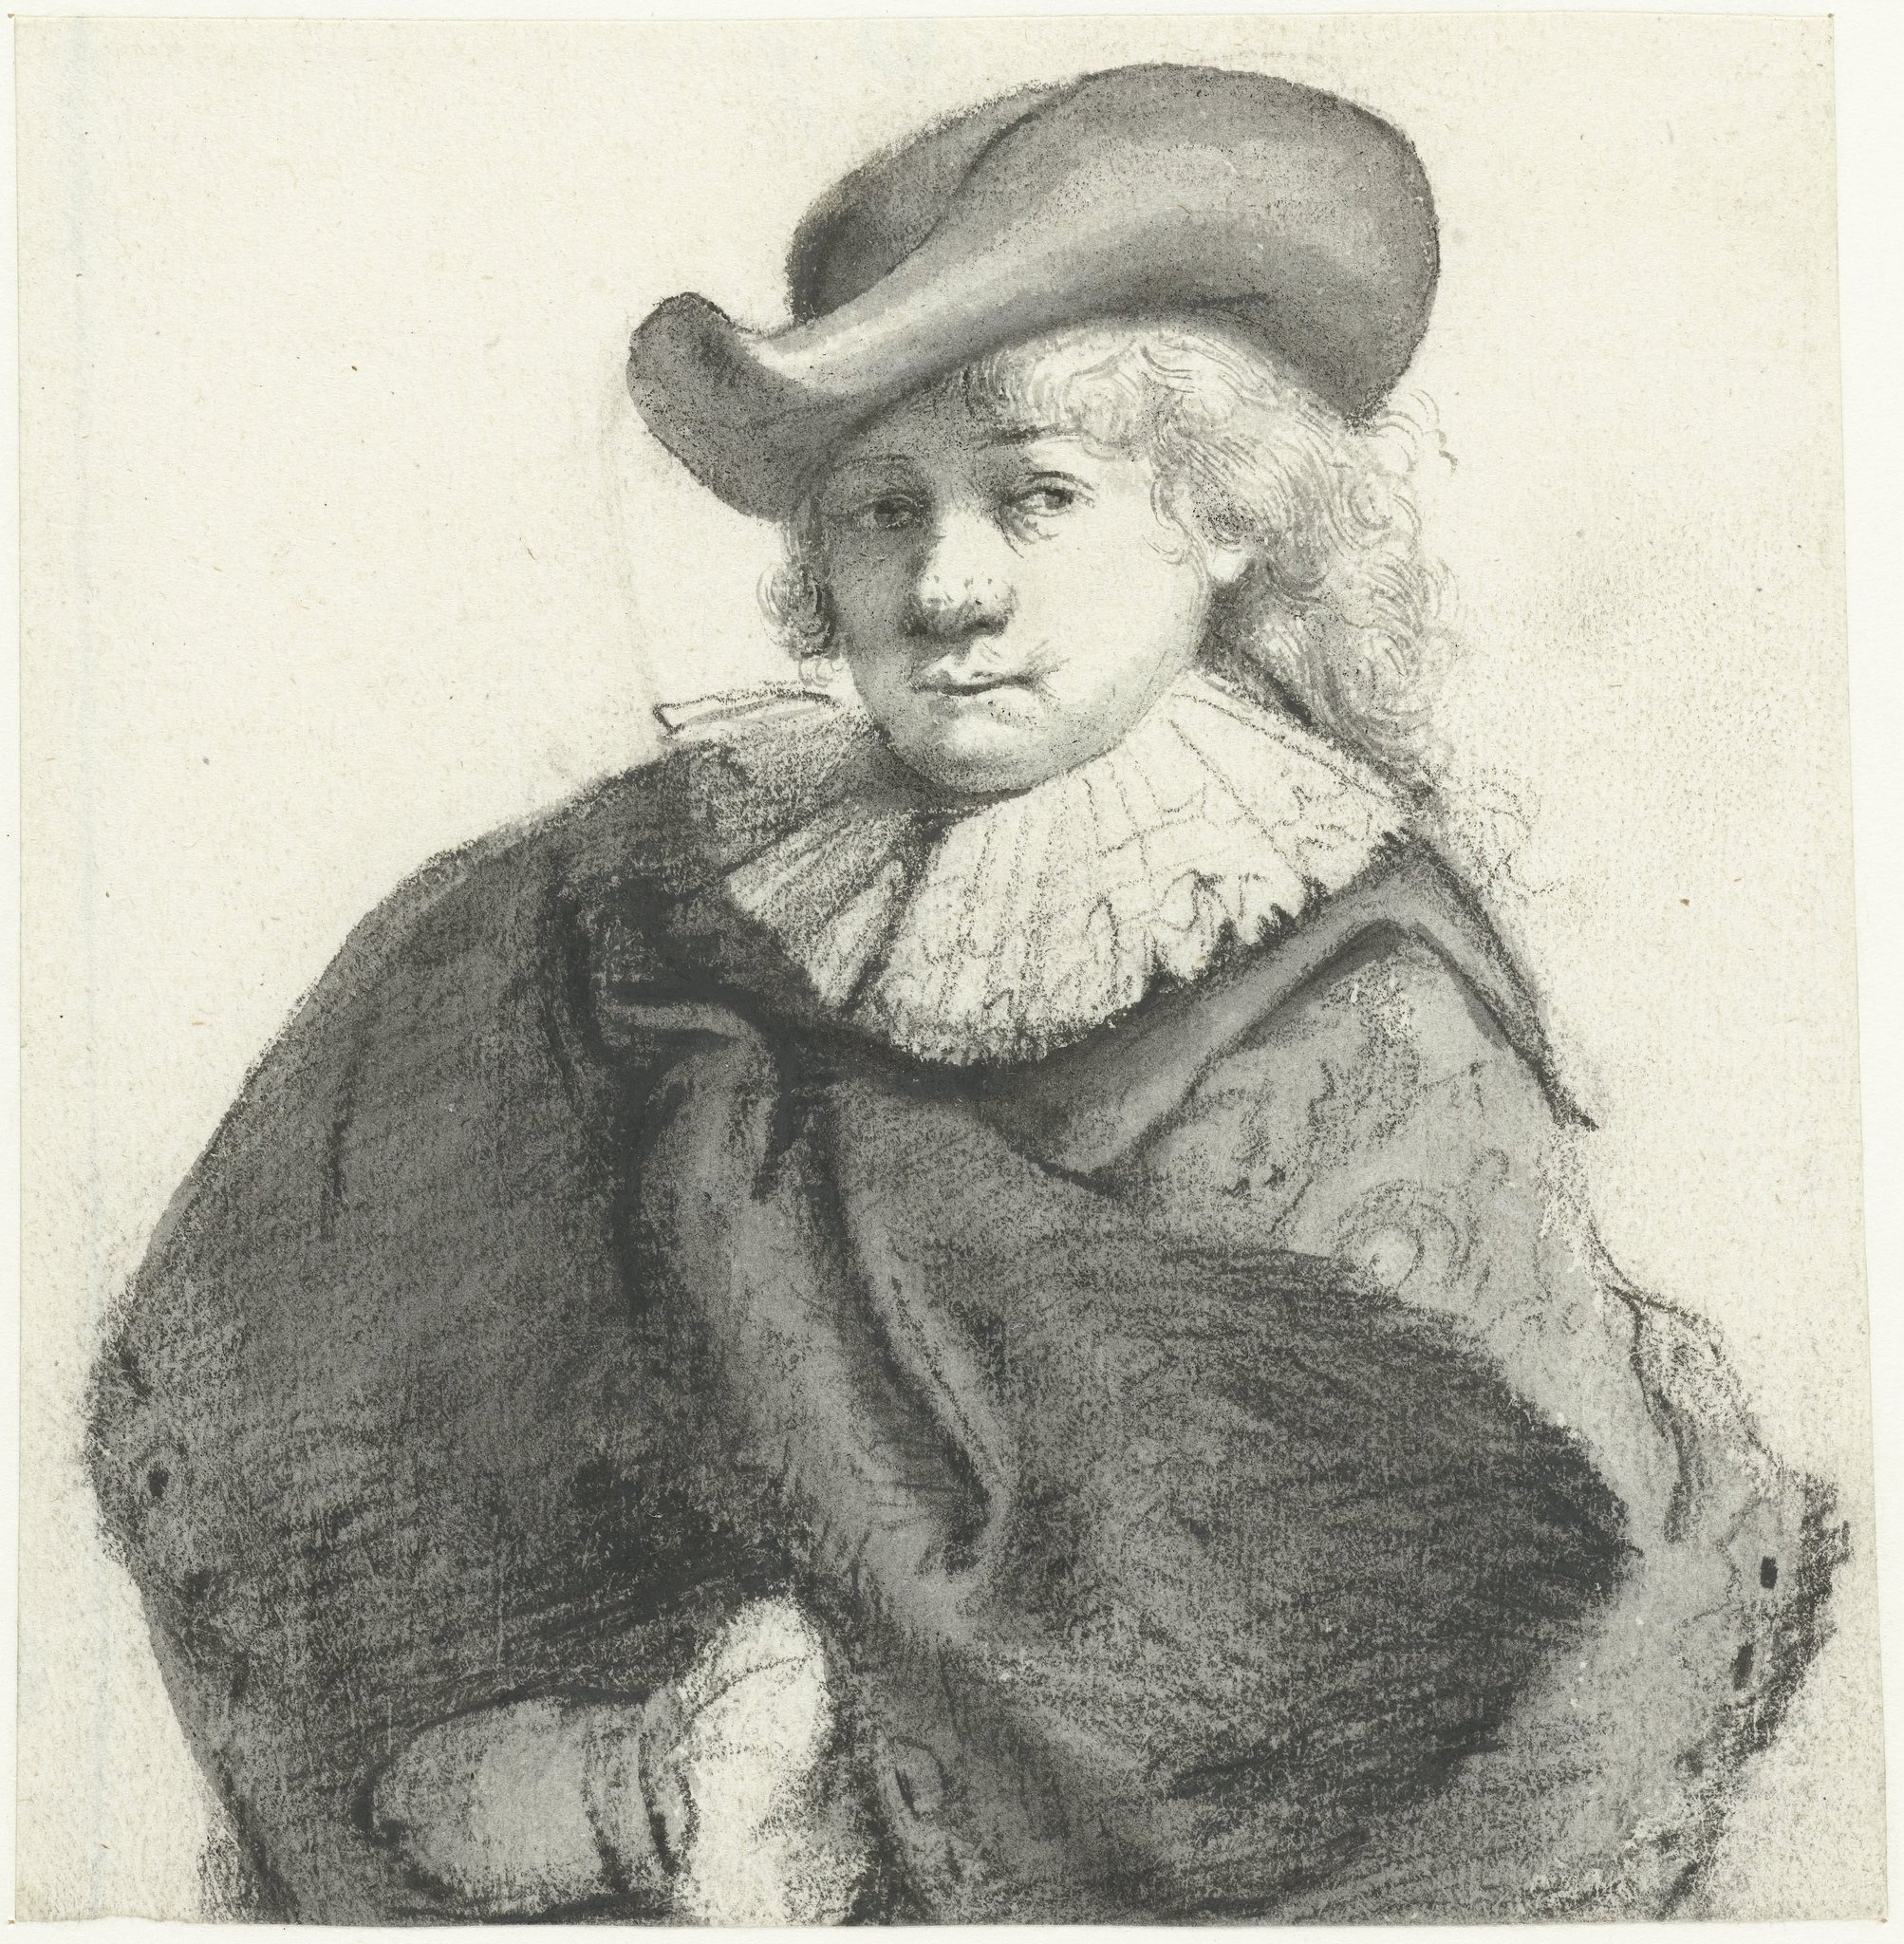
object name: drawing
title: Portret van Rembrandt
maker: moses ter borch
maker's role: draughtsman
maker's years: 1645-1667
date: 1660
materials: chalk, ink, paper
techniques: brush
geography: zwolle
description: Naar geëtst zelfportret van Rembrandt van Rijn, Bar 7, 1631.